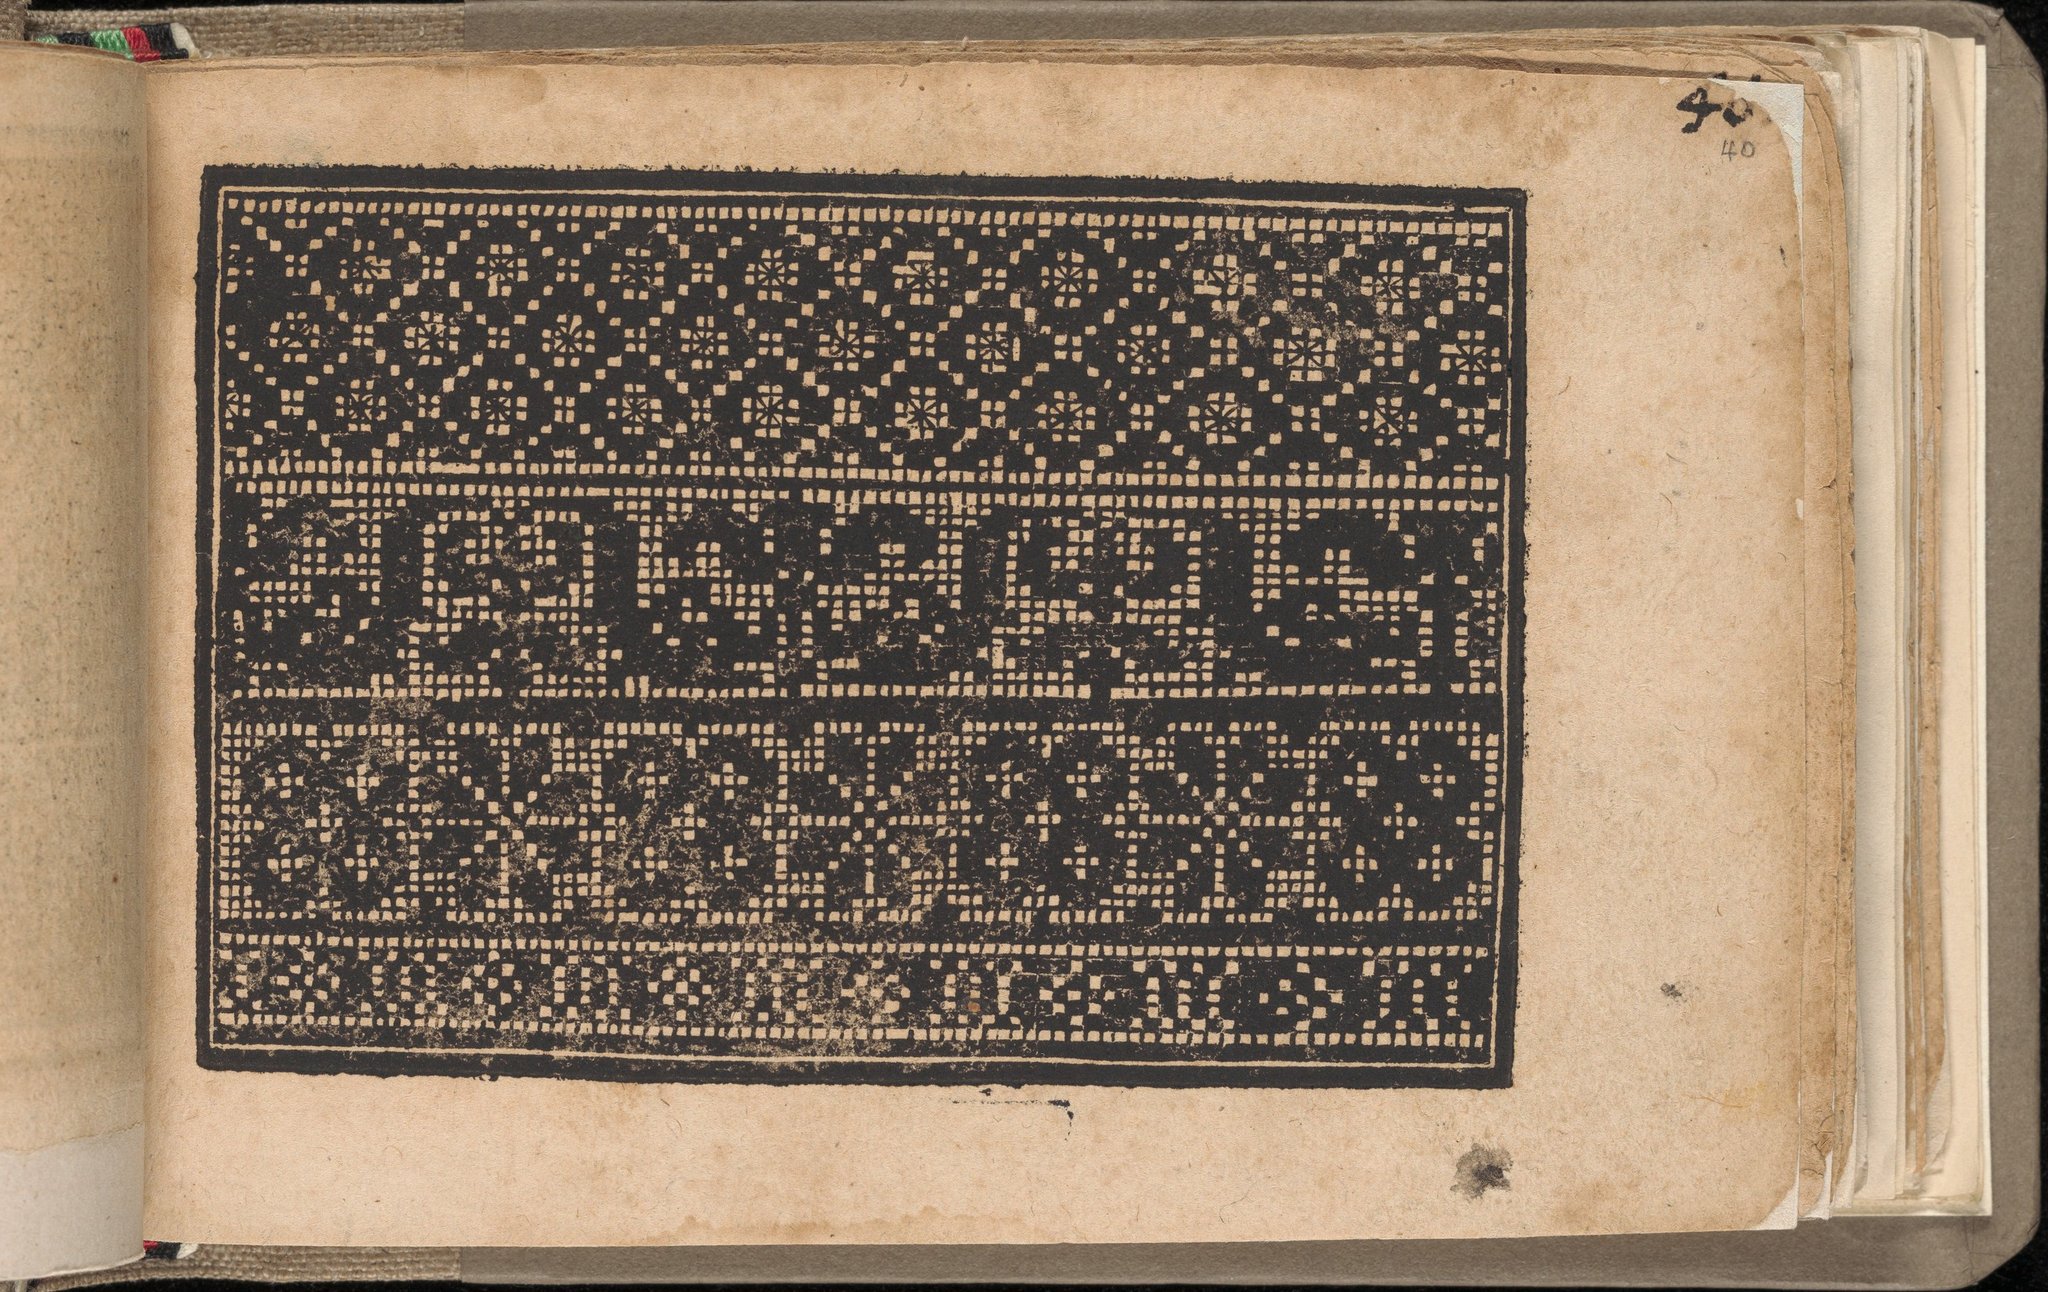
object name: book print ornament architecture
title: Schön newes Modelbuch (Page 40r)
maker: sigismundus latomus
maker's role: publisher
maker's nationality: german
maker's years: 1599-1632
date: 1608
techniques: woodcut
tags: ornament